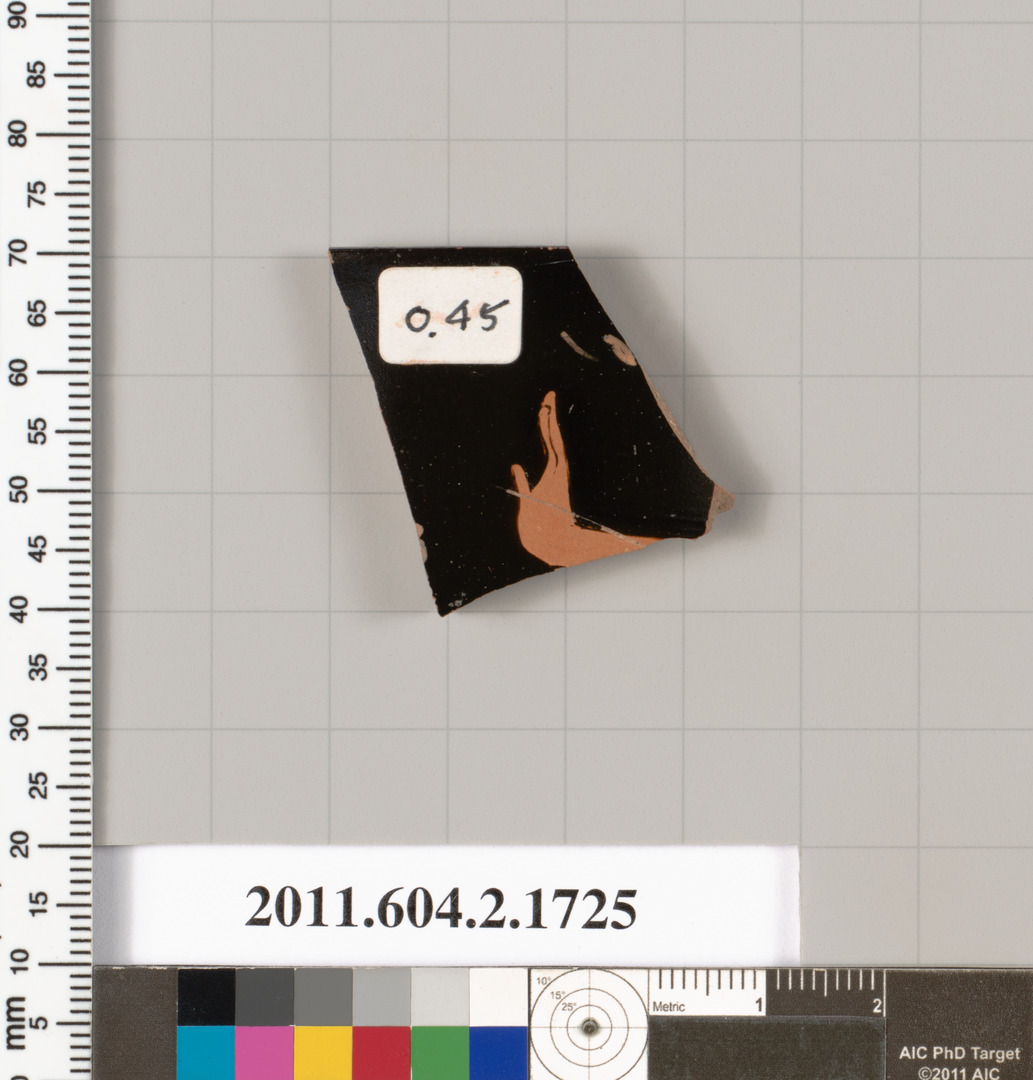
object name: skyphos fragment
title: Terracotta rim fragment of a skyphos (deep drinking cup)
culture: greek, attic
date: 475-451 BCE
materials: terracotta